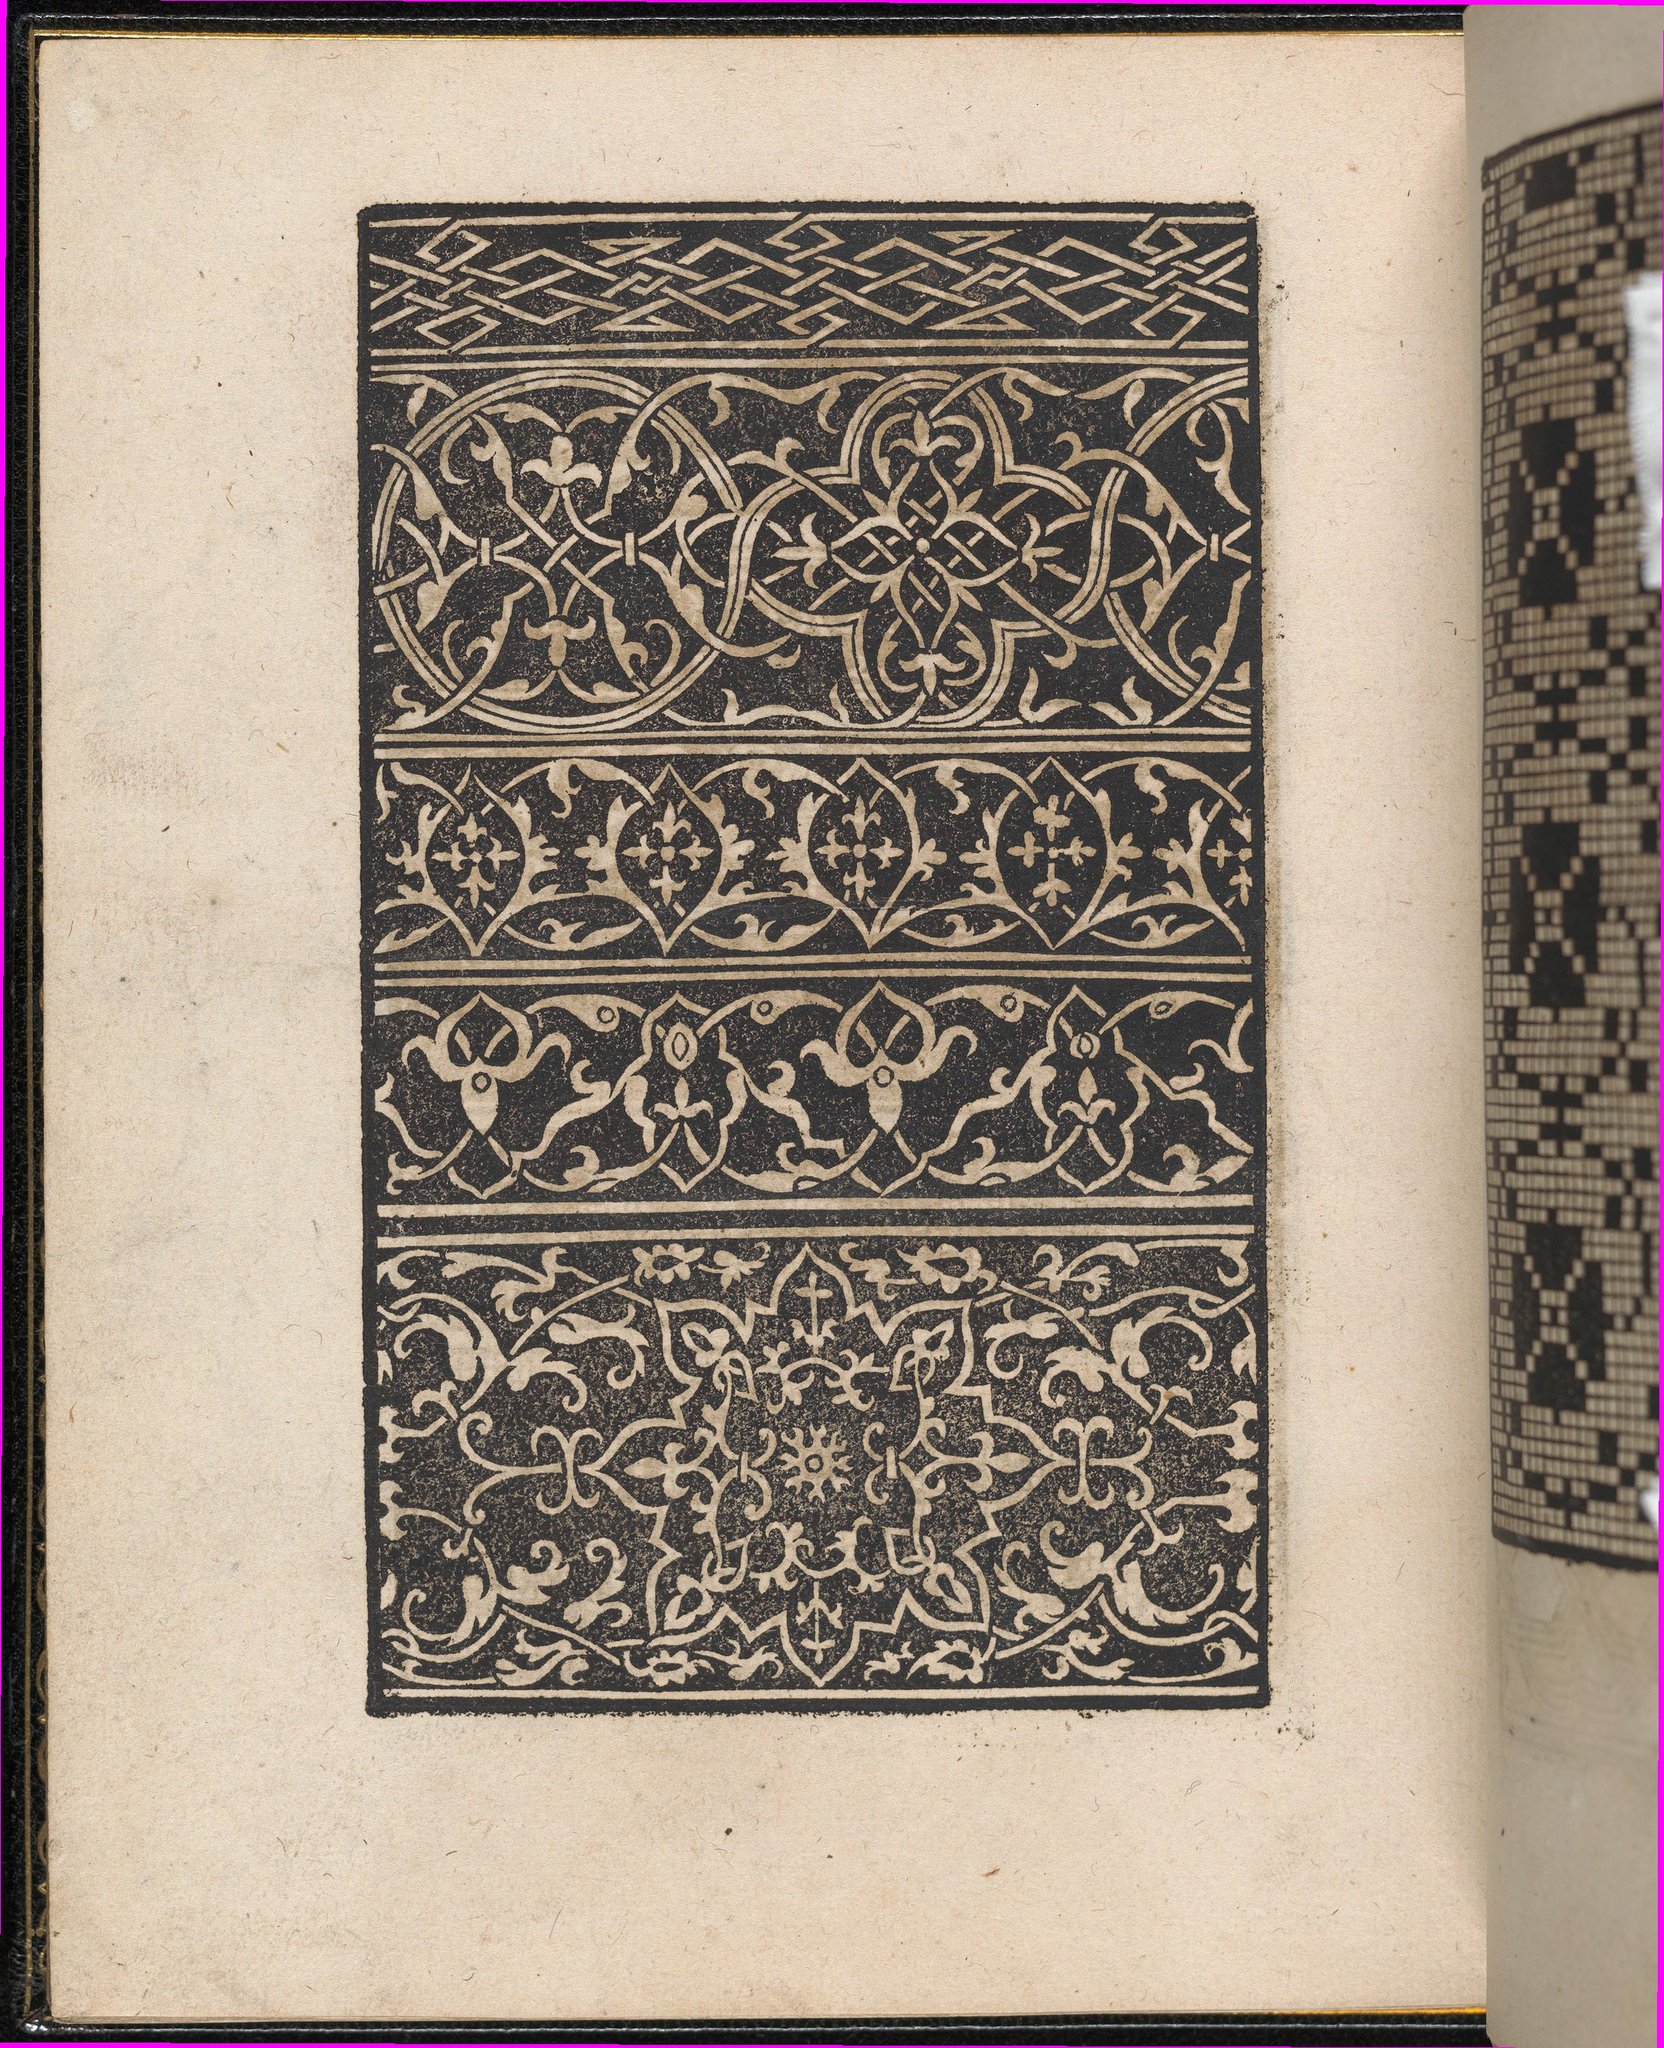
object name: book print ornament architecture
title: Page from Ein new kunstlich Modelbuch...(Page 49v)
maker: peter quentel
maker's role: publisher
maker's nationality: german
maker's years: 1500-1550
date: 1544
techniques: woodcut